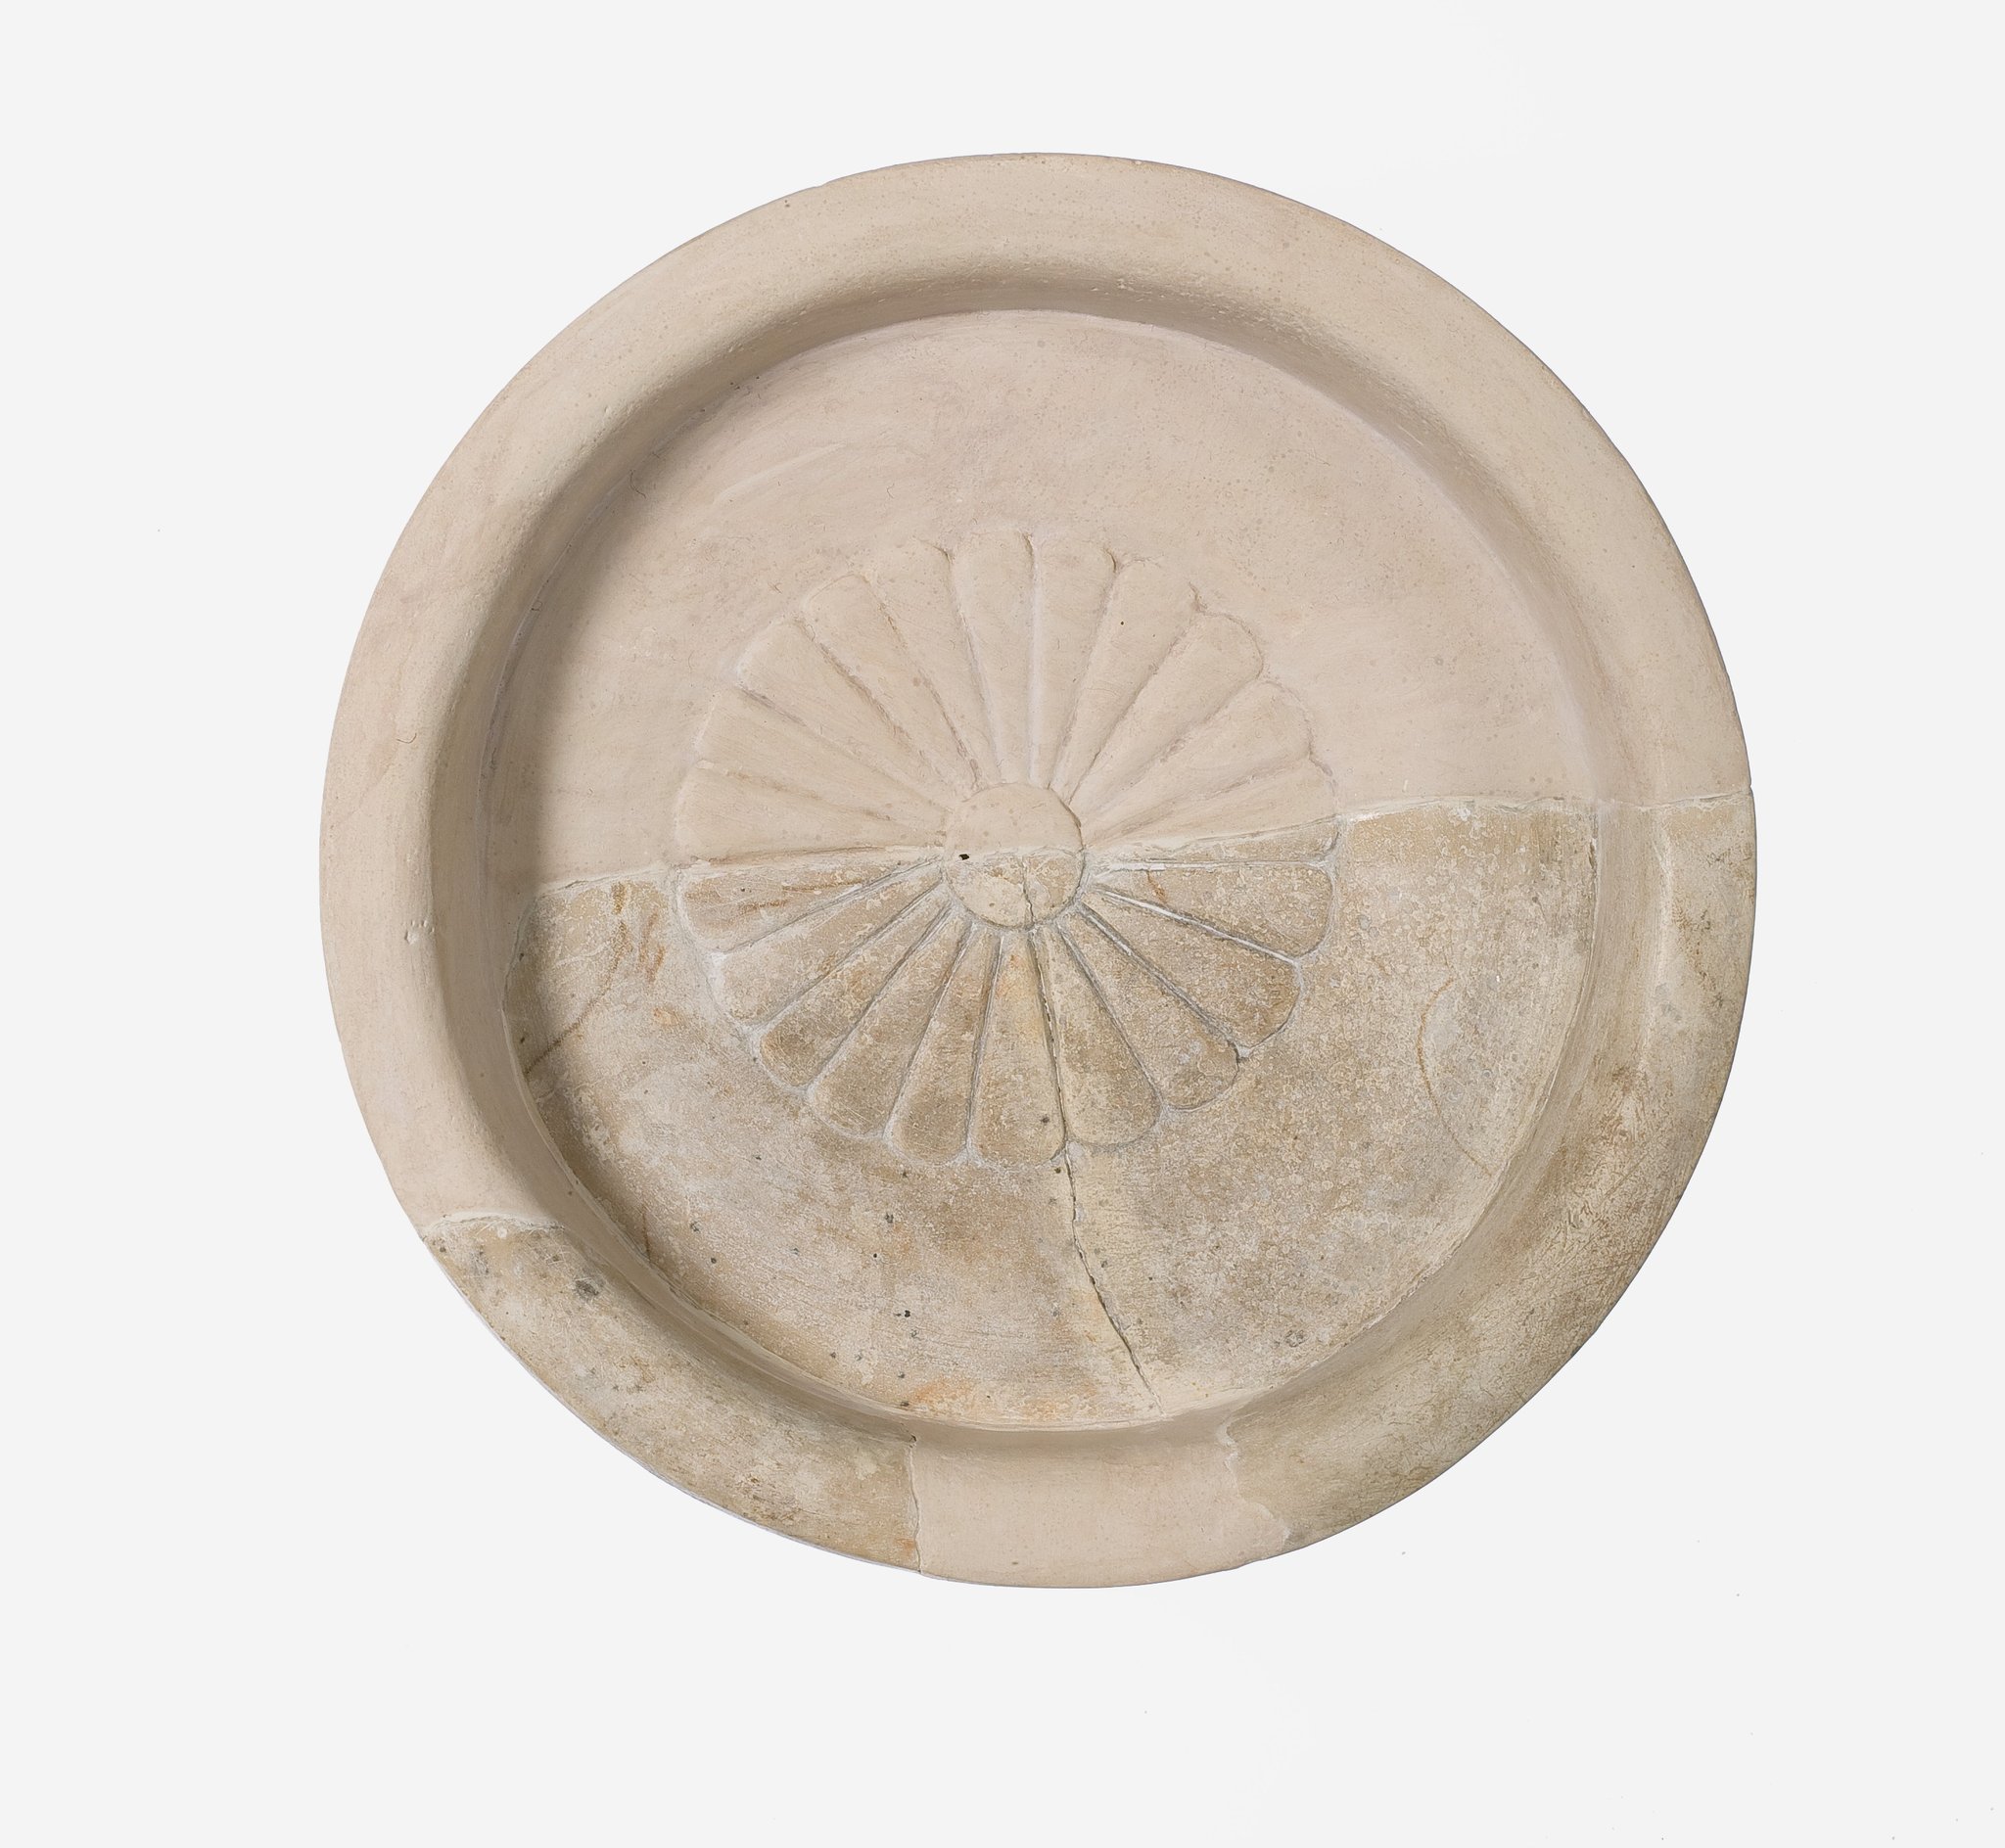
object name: dish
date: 1390-1352 BCE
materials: limestone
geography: egypt